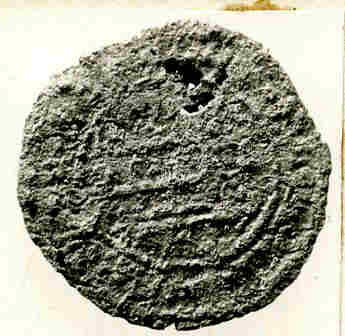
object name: coin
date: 734-766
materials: copper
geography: iran